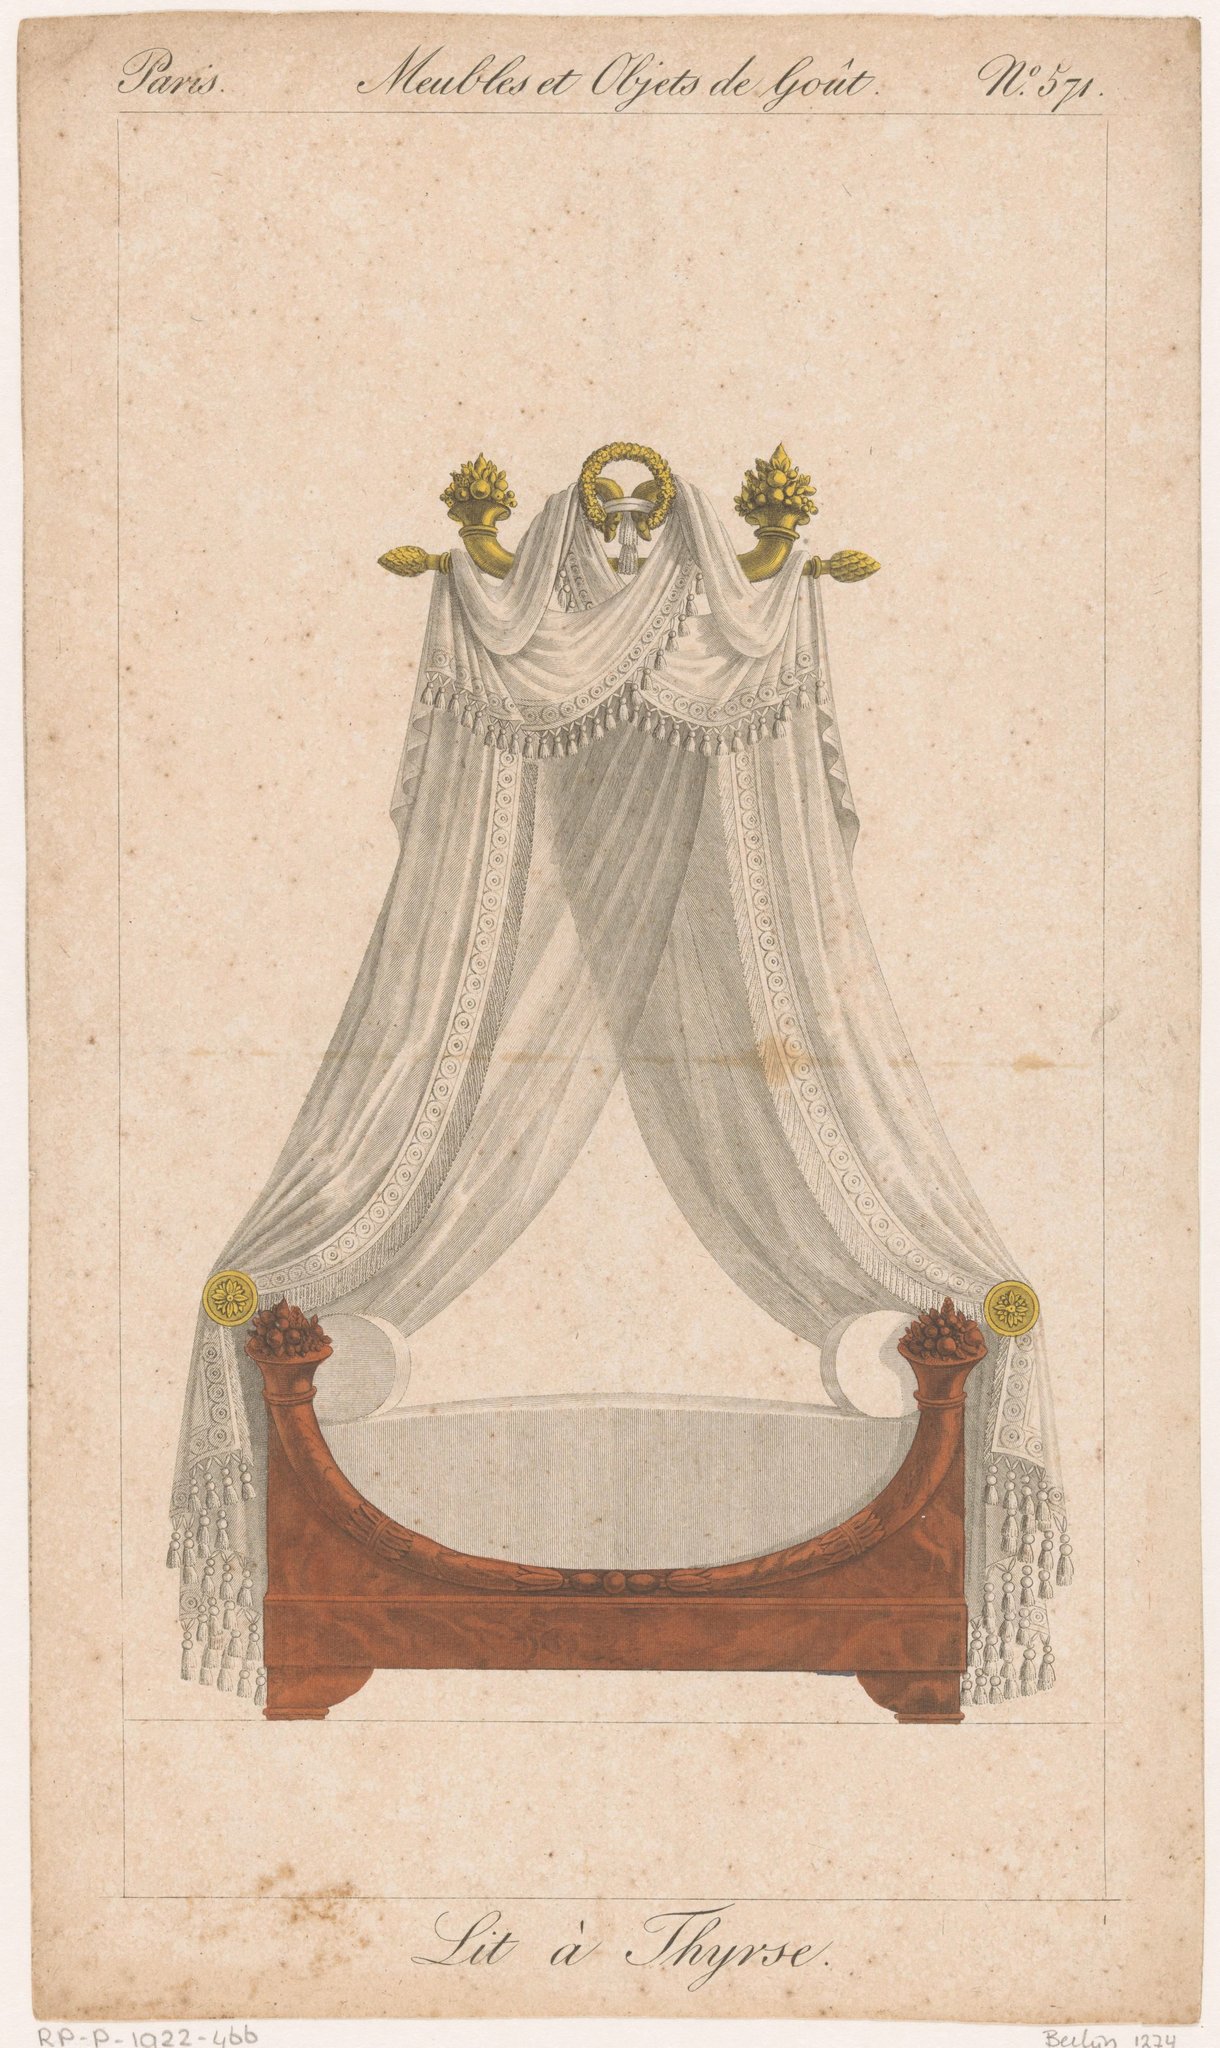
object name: ornament print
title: Meubles et Objets de Goût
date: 1801-1831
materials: paper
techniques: engraving, hand coloring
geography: paris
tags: bed with tester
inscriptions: collector's mark: Lugt 2233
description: Een ontwerp voor een hemelbed gedecoreerd met hoornen des overvloeds. De bekroning is gedecoreerd met een lauwerkrans, hoornen des overvloeds en twee thyrsi. Prentnummer 571.